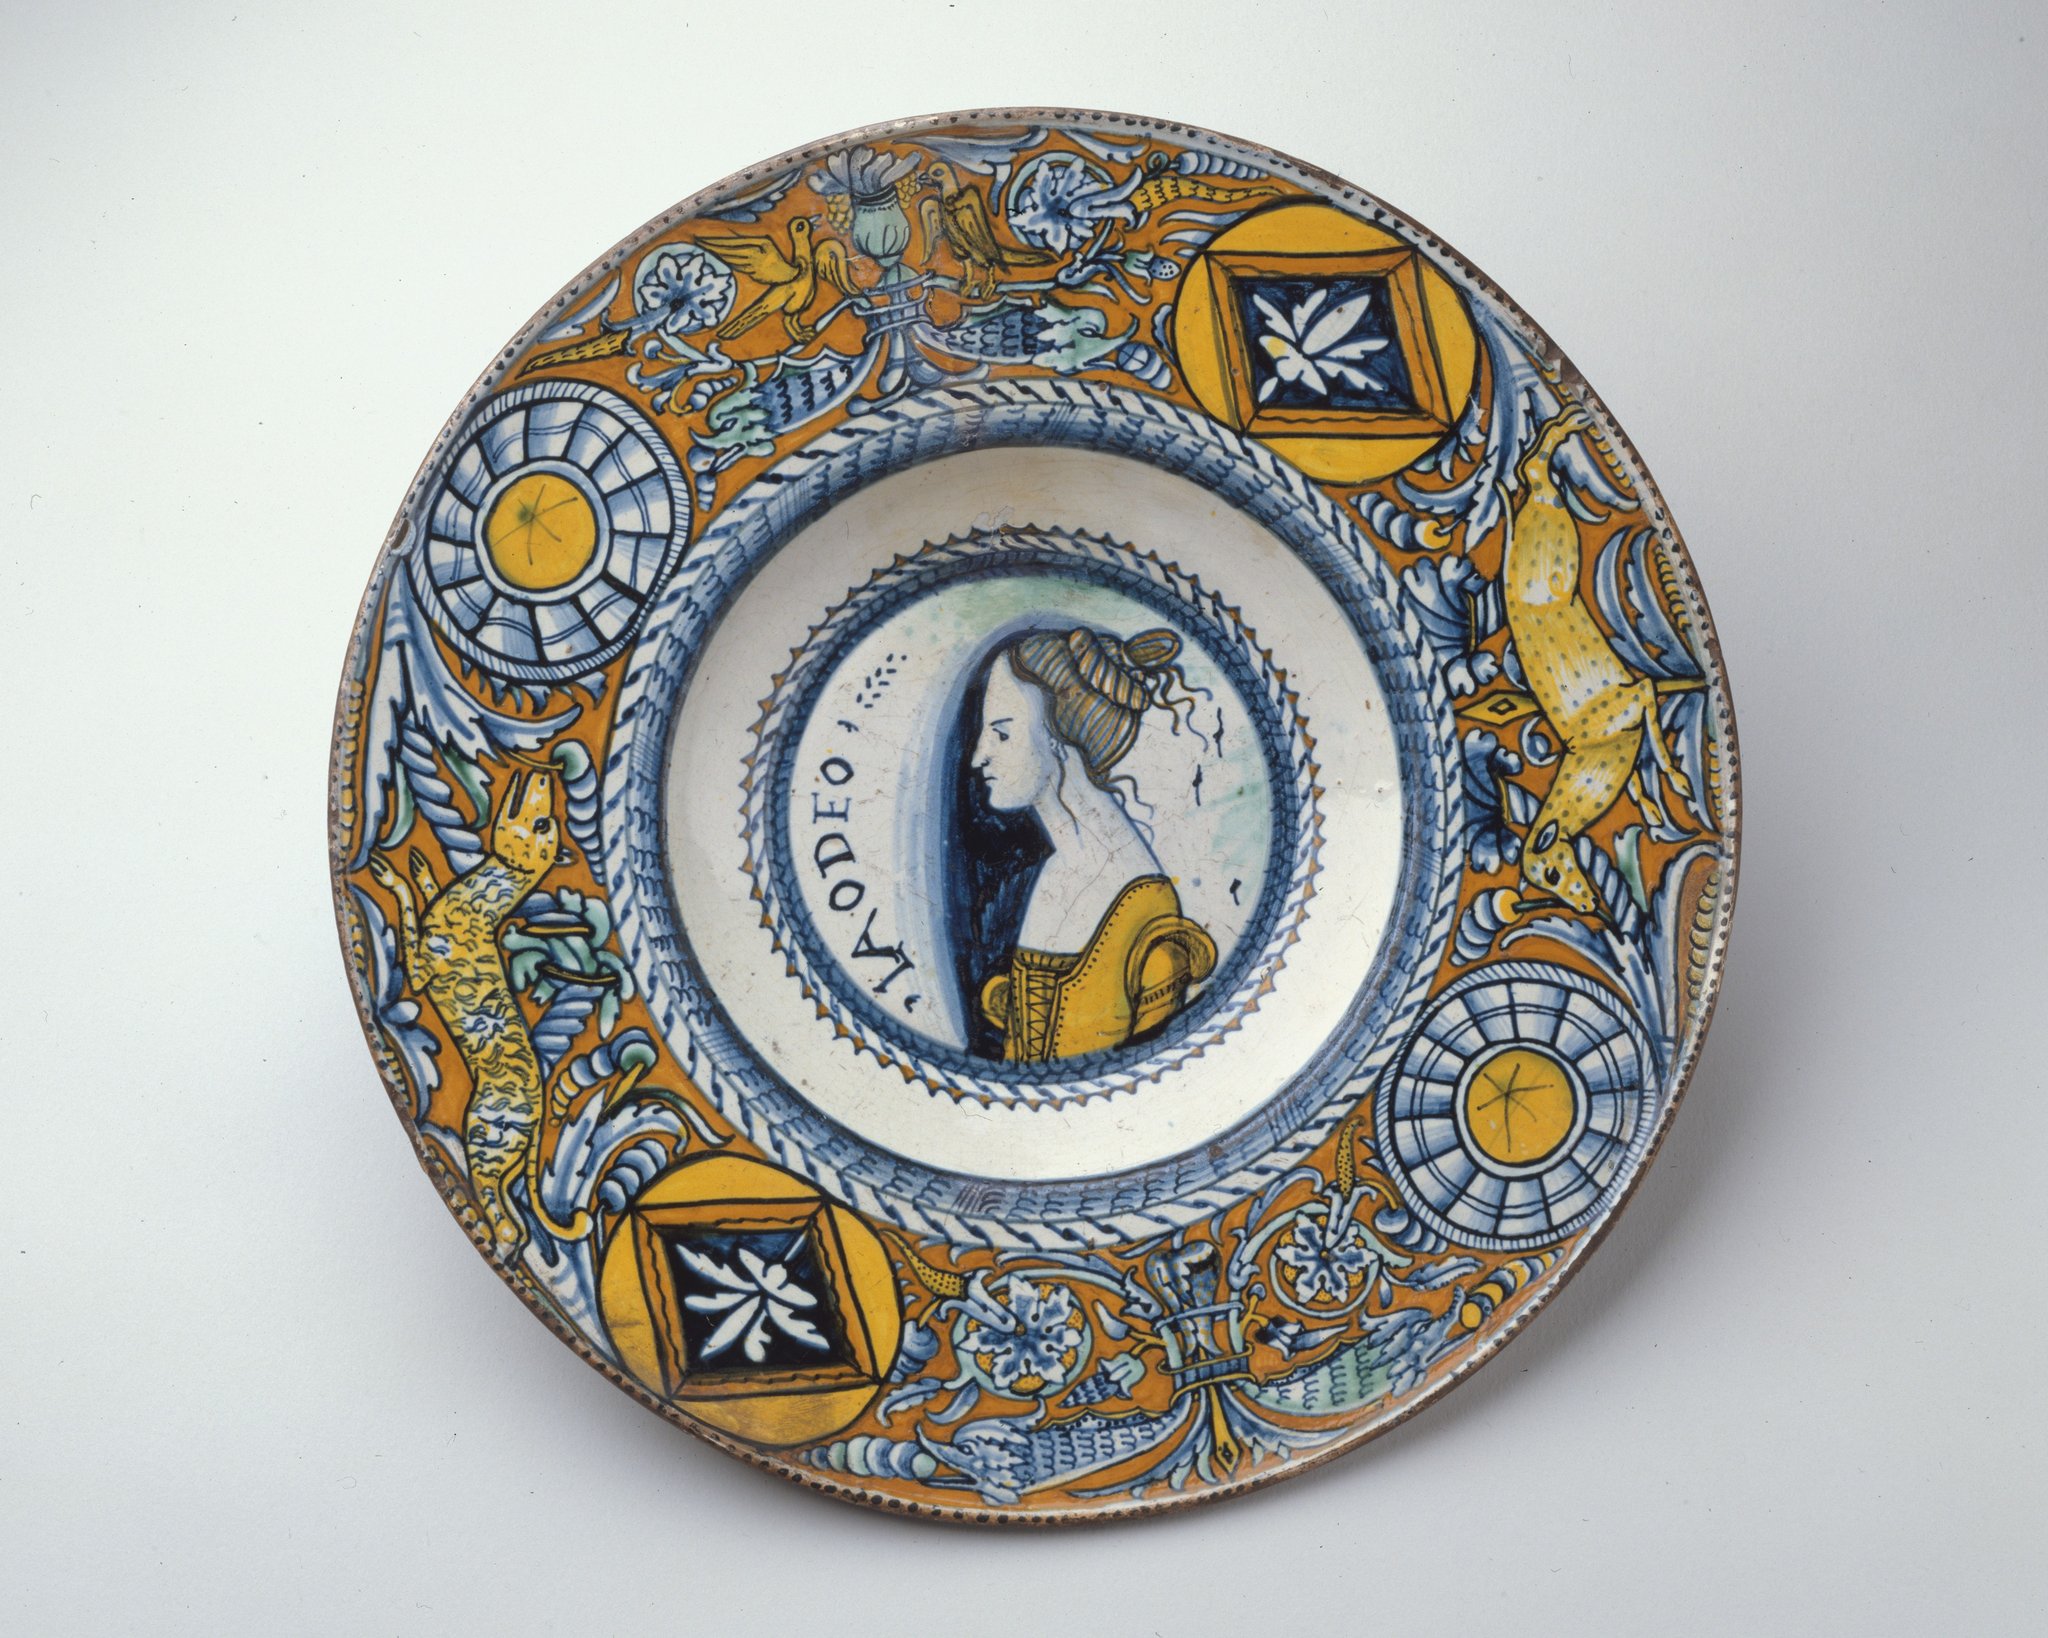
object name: plate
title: Plate (tagliere)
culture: italian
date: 1500-1510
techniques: maiolica, glazing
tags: animals,women